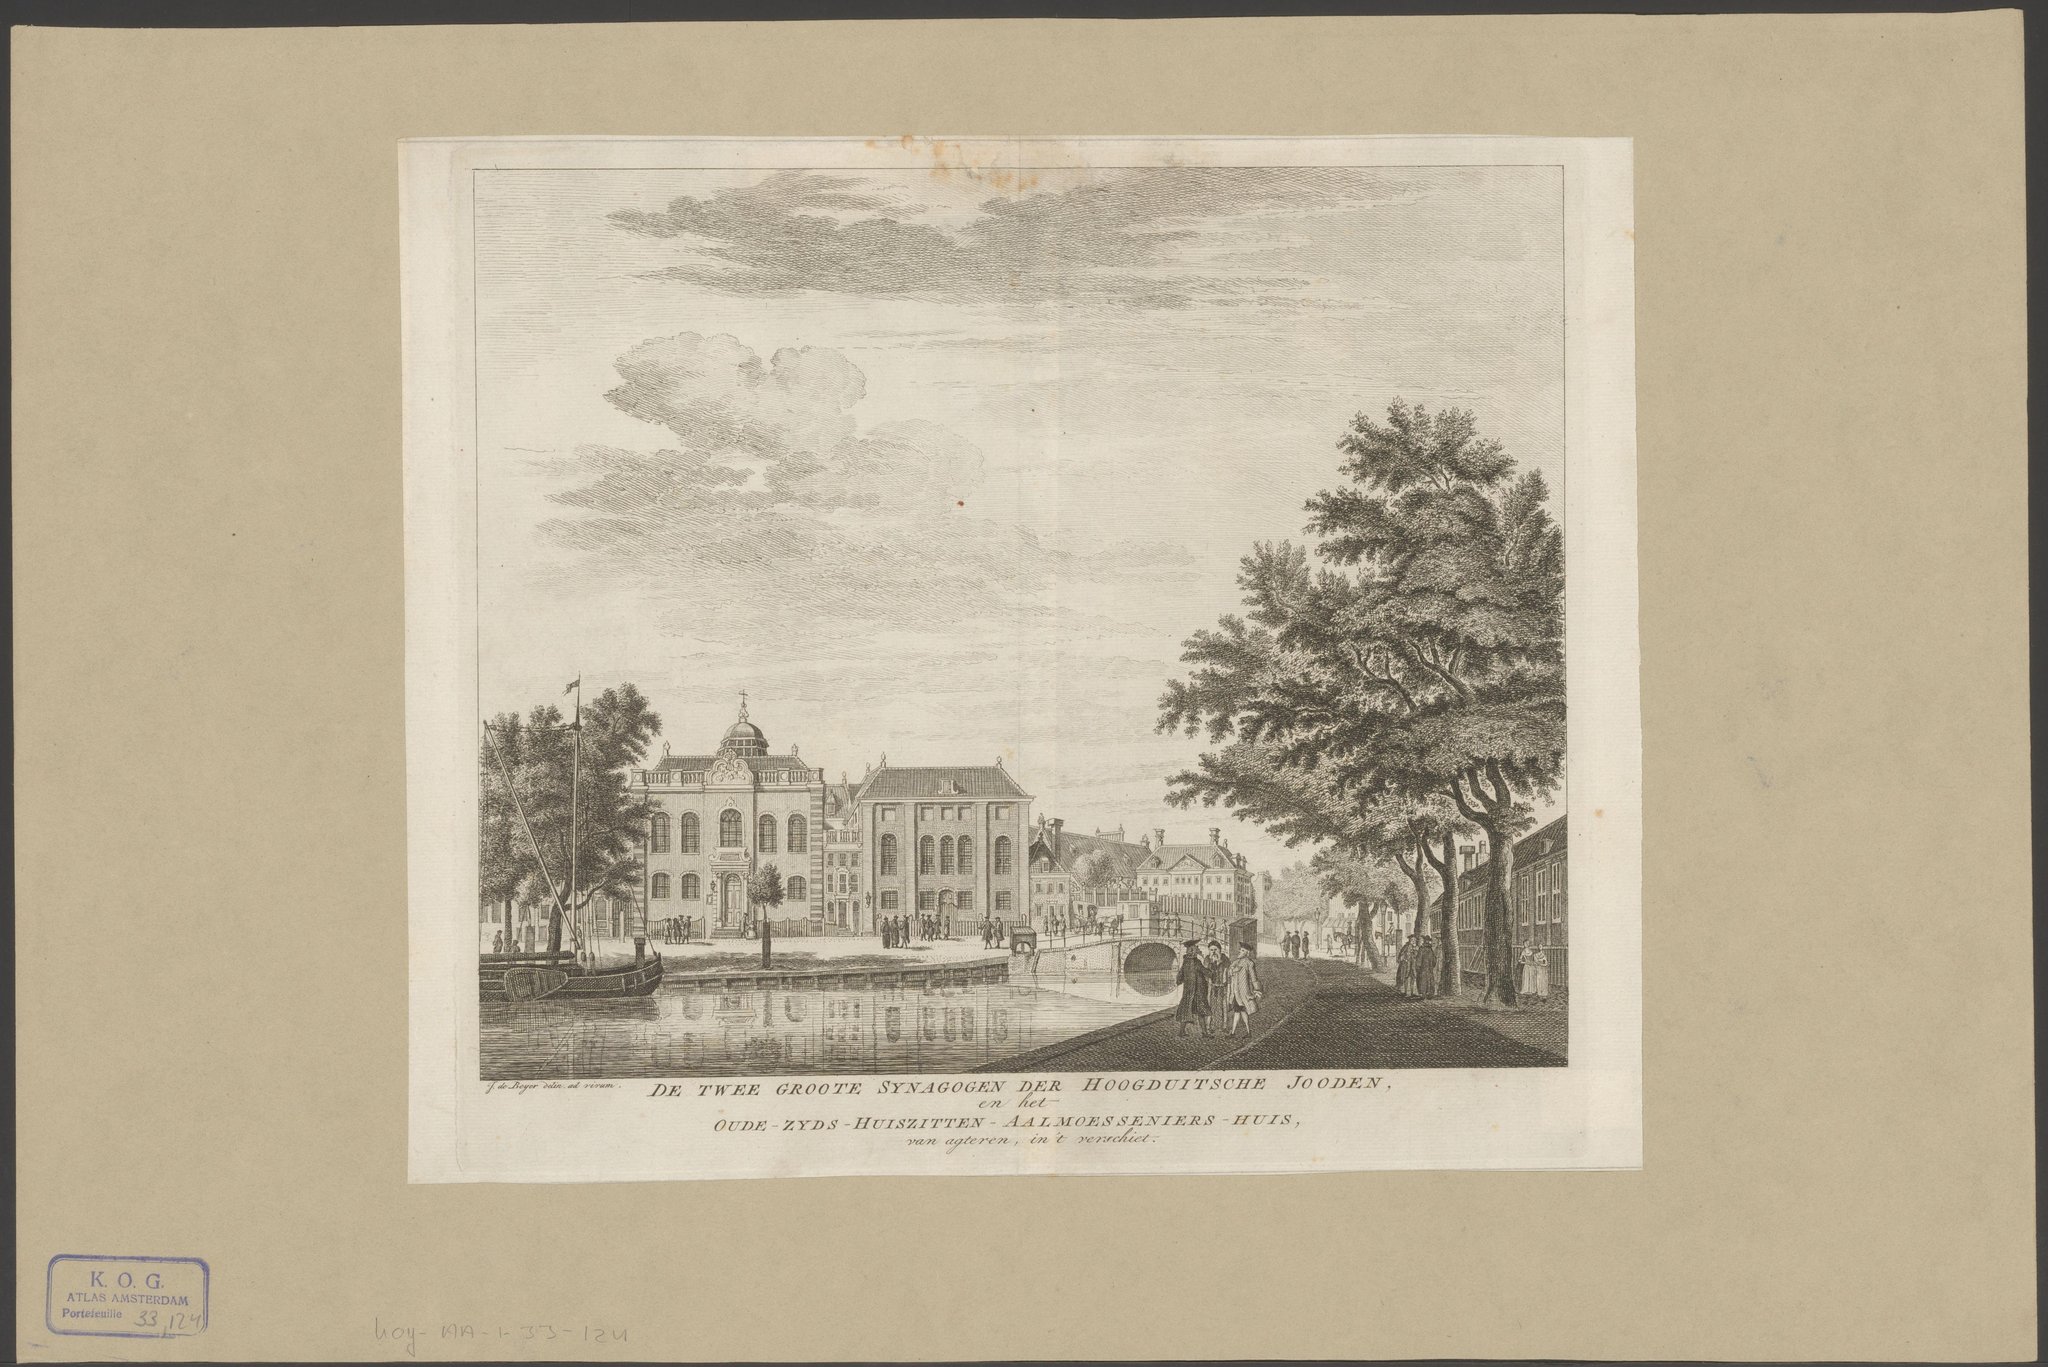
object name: print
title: De twee groote Synagogen der Hoogduitsche Jooden, en het Oude Zyds-Huiszitten-Aalmoesseniers-Huis, van agteren, in 't verschiet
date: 1765-1782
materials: paper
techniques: engraving, etching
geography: harlingen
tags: the synagogue (as building and place of worship ~ jewish religion), canals, waters (in city) (+ city(-scape) with figures, staffage)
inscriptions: collector's mark: Lugt 1641b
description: Prent mogelijk uit: Wagenaar, Jan. Amsterdam, in zyne opkomst, aanwas, geschiedenissen (…). Amsterdam: Isaak Tirion, 1765, dl. 2. Of uit: Verzameling der fraaiste gezigten van Amsterdam in negen en zeventig afbeeldingen. Amsterdam en Harlingen: Petrus Conradi en Volkert van der Plaats, 1782.